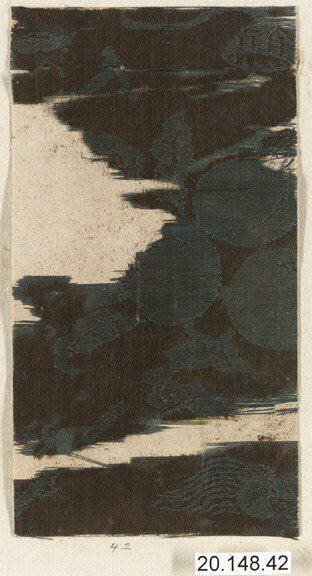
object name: piece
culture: china or japan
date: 1601-1700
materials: silk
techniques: compound weave